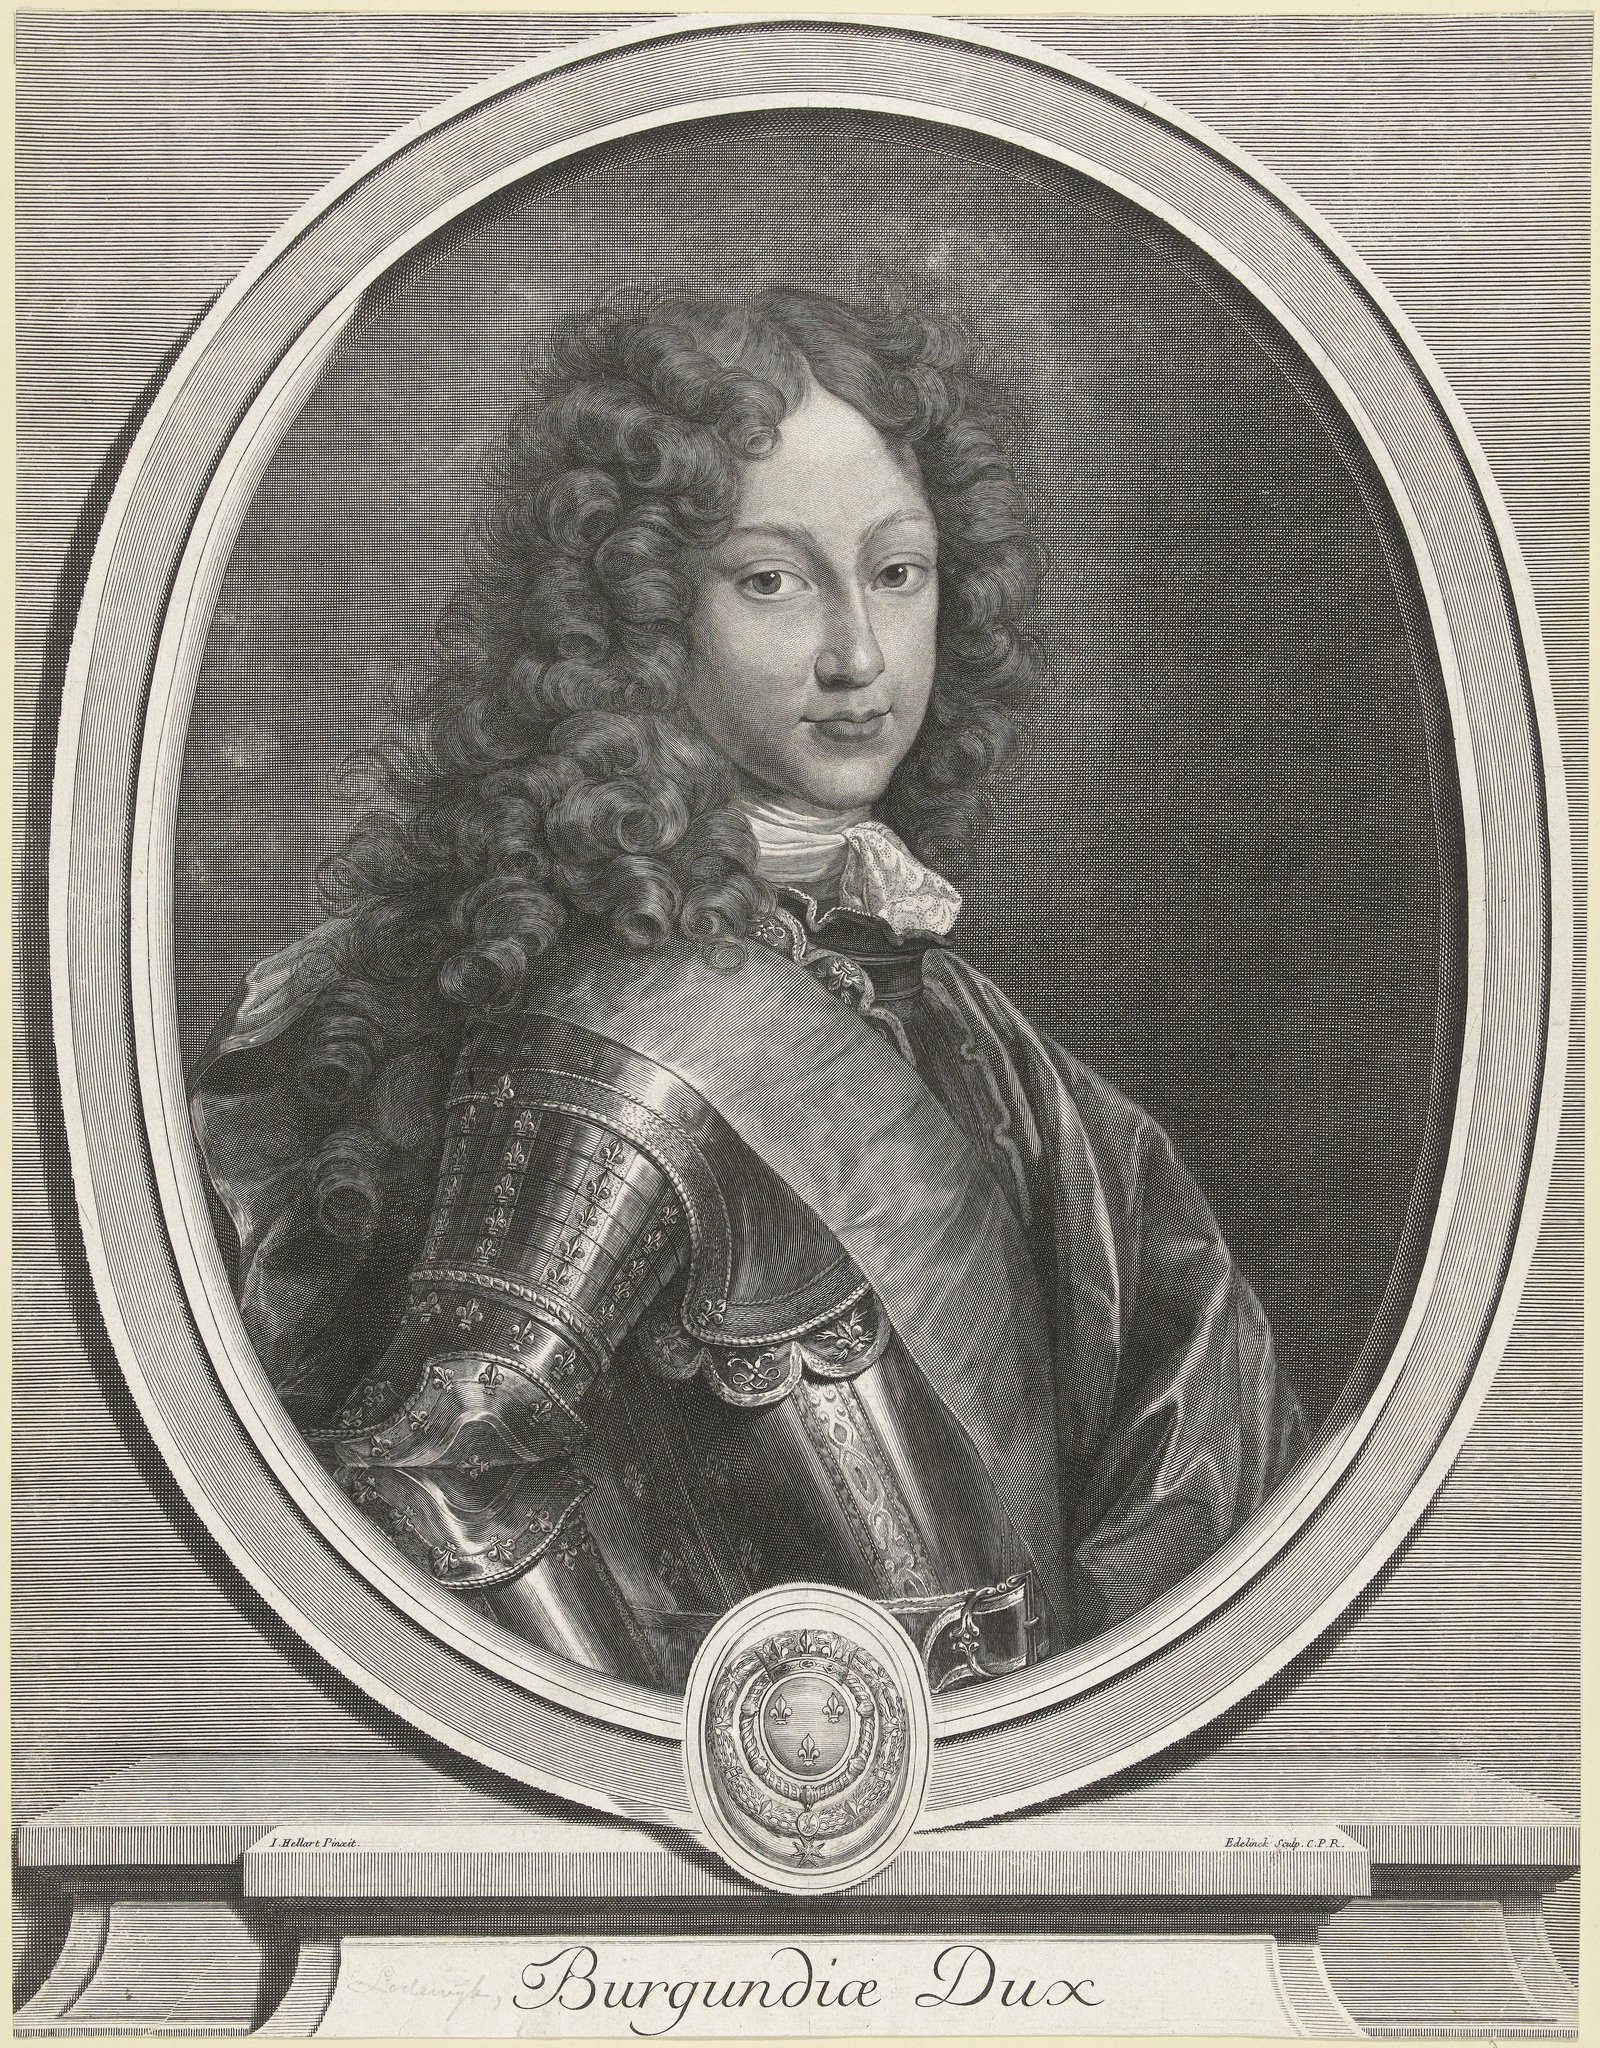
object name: print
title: Portret van Lodewijk van Frankrijk, hertog van Bourgondië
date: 1675-1707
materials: paper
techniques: engraving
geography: france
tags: lodewijk van frankrijk (hertog van bourgondië)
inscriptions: collector's mark: Lugt 240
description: Portret van Lodewijk van Frankrijk (Lodewijk van Bourgogne), hertog van Bourgondië. Afgebeeld ten halven lijve, in hofkleding, binnen een ovale omlijsting met wapen.